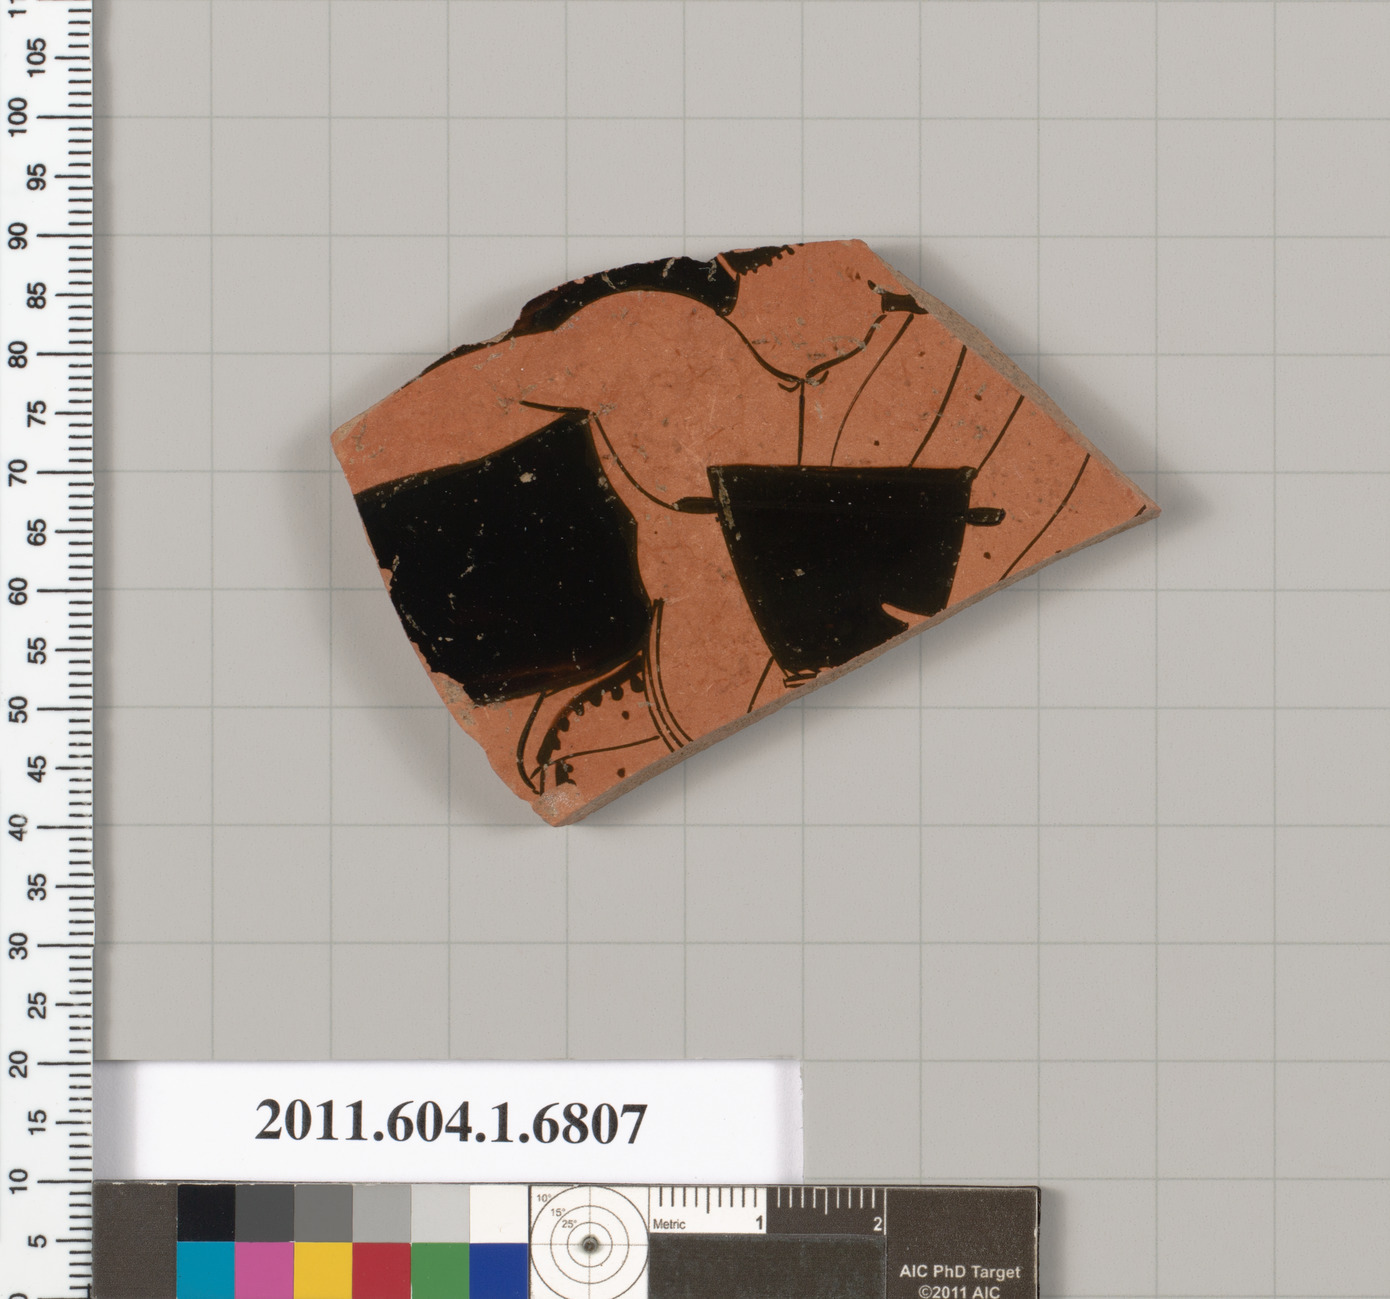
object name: kylix fragment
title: Terracotta fragment of a kylix (drinking cup)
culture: greek, attic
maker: painter of the paris gigantomachy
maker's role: artist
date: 490-480 BCE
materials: terracotta